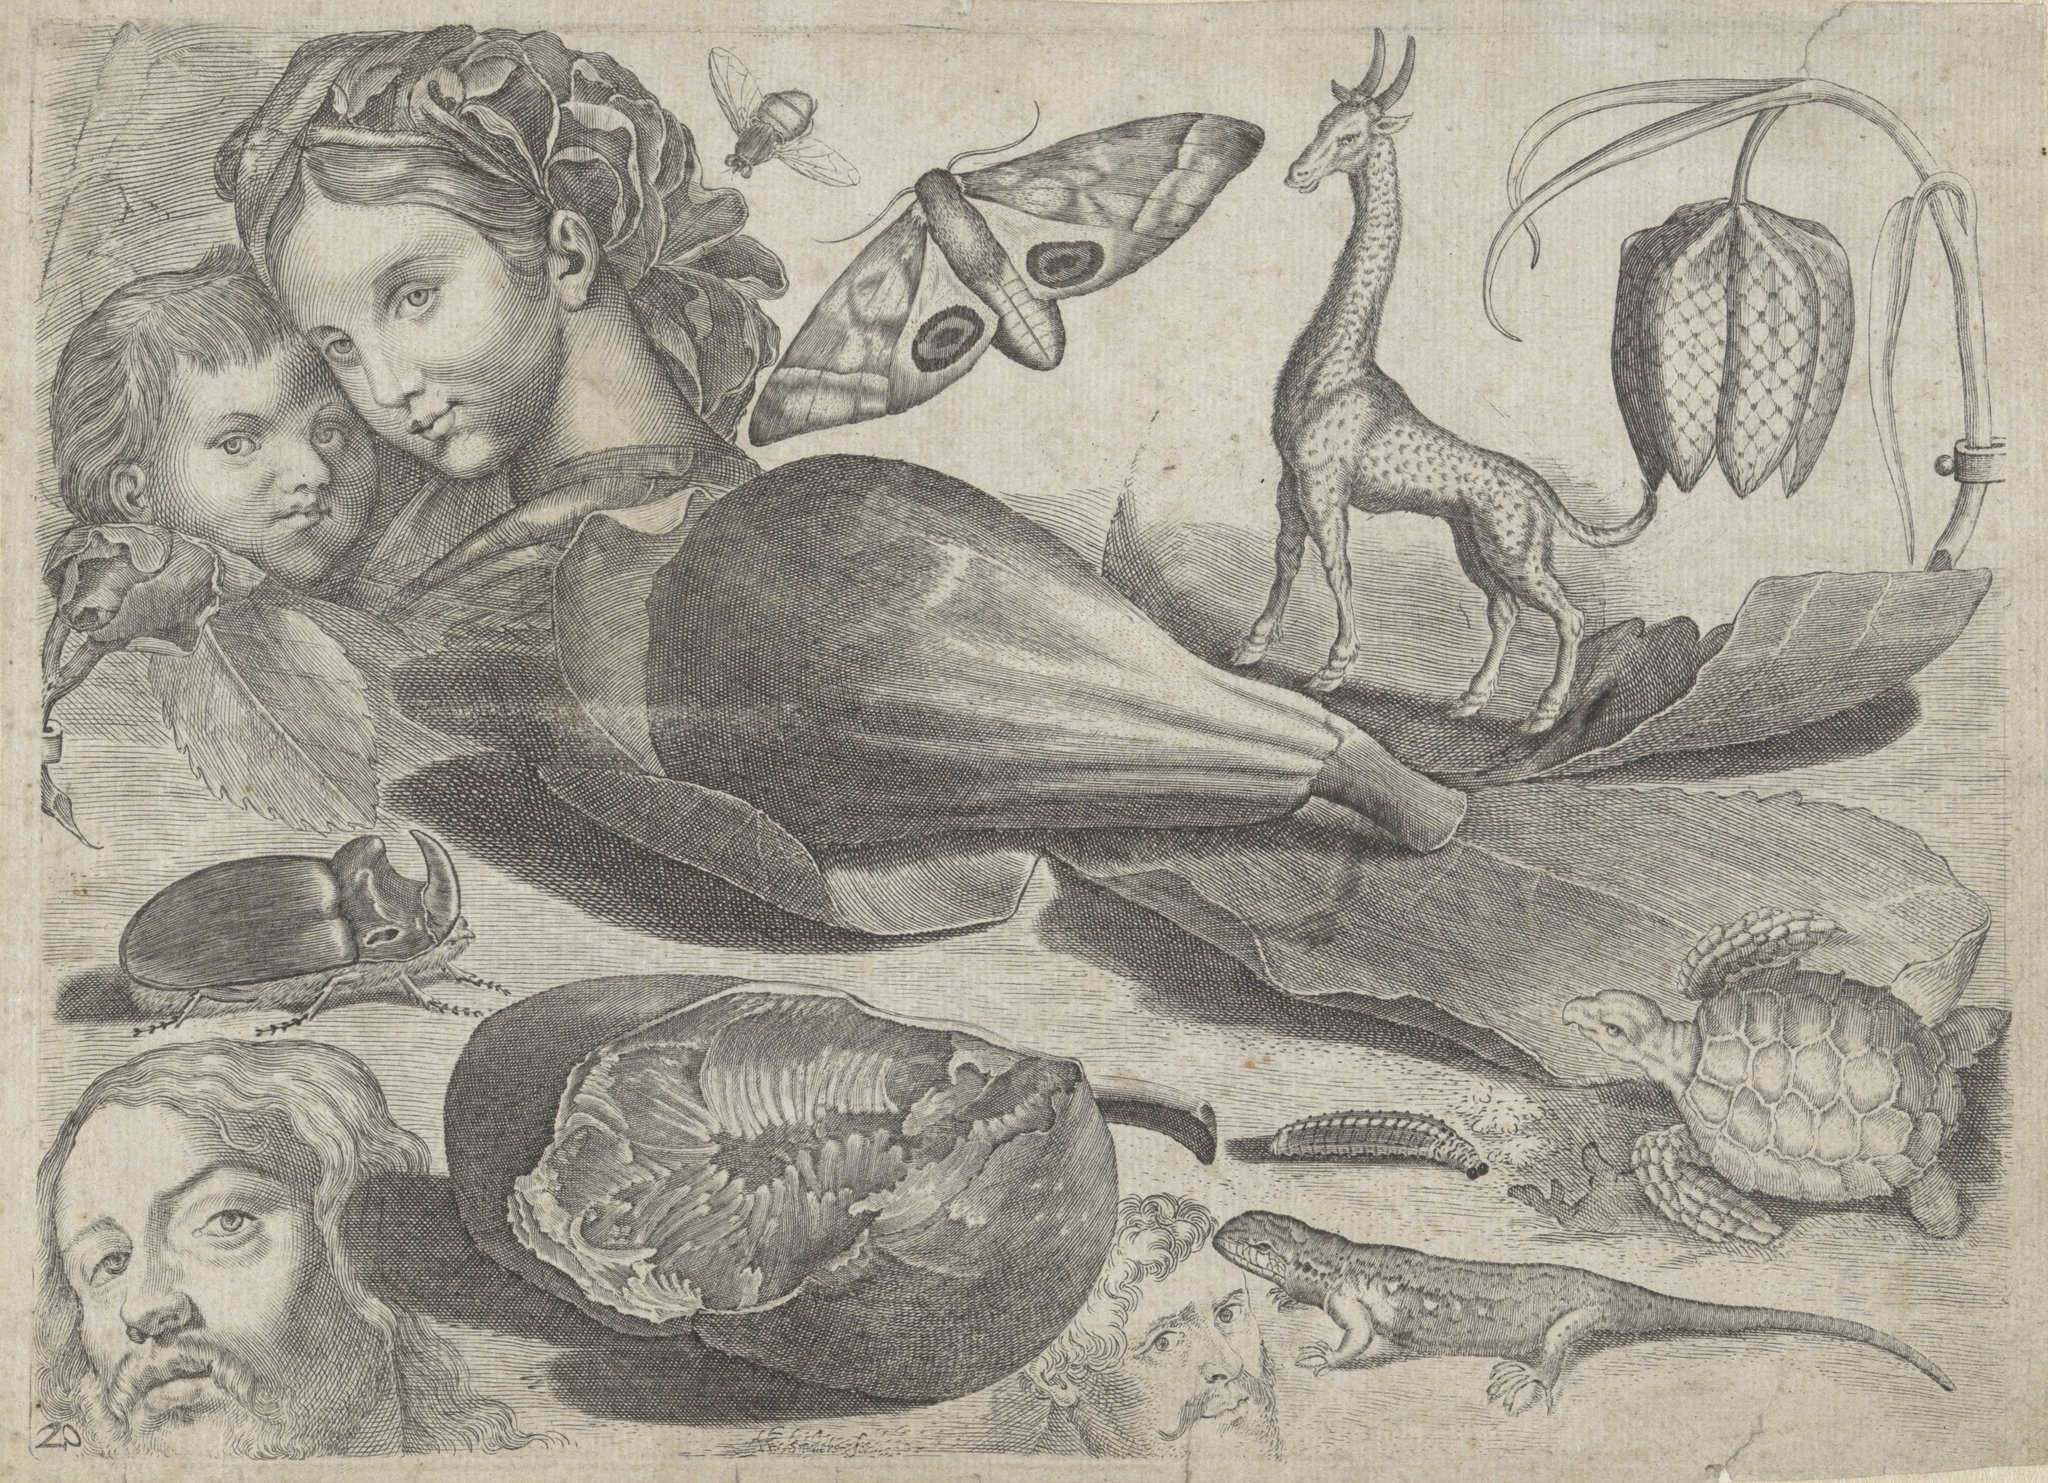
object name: print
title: Tekenvoorbeelden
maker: michael snijders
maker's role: print maker, publisher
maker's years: 1586-1672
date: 1610-1672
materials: paper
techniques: engraving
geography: antwerp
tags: head (human), cut flowers; nosegay, bunch of flowers, madonna: i.e. mary with the christ-child, tortoises, turtles, fruits: fig, model-books ~ implements of painter, trees: fig-tree (leaves, putting forth leaves), lizards: lizard, insects: butterfly, insects, hoofed animals: giraffe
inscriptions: collector's mark: Lugt 3751, collector's mark: Lugt 2228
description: Twintigste prent uit een serie met tekenvoorbeelden. Studieblad met fruit, dieren en koppen. In het midden een vijg op bijbehorend blad, eronder een opengesneden vijg. Aan weerszijden dieren: een neushoornkever, rups, hagedis en zeeschildpad. Eronder twee koppen. Linksboven een Madonna met Christuskind (naar Rafaël). Rechtsboven een kievitsbloem, ernaast een giraffe. In het midden een insect en een pauwoogpijlstaartvlinder.